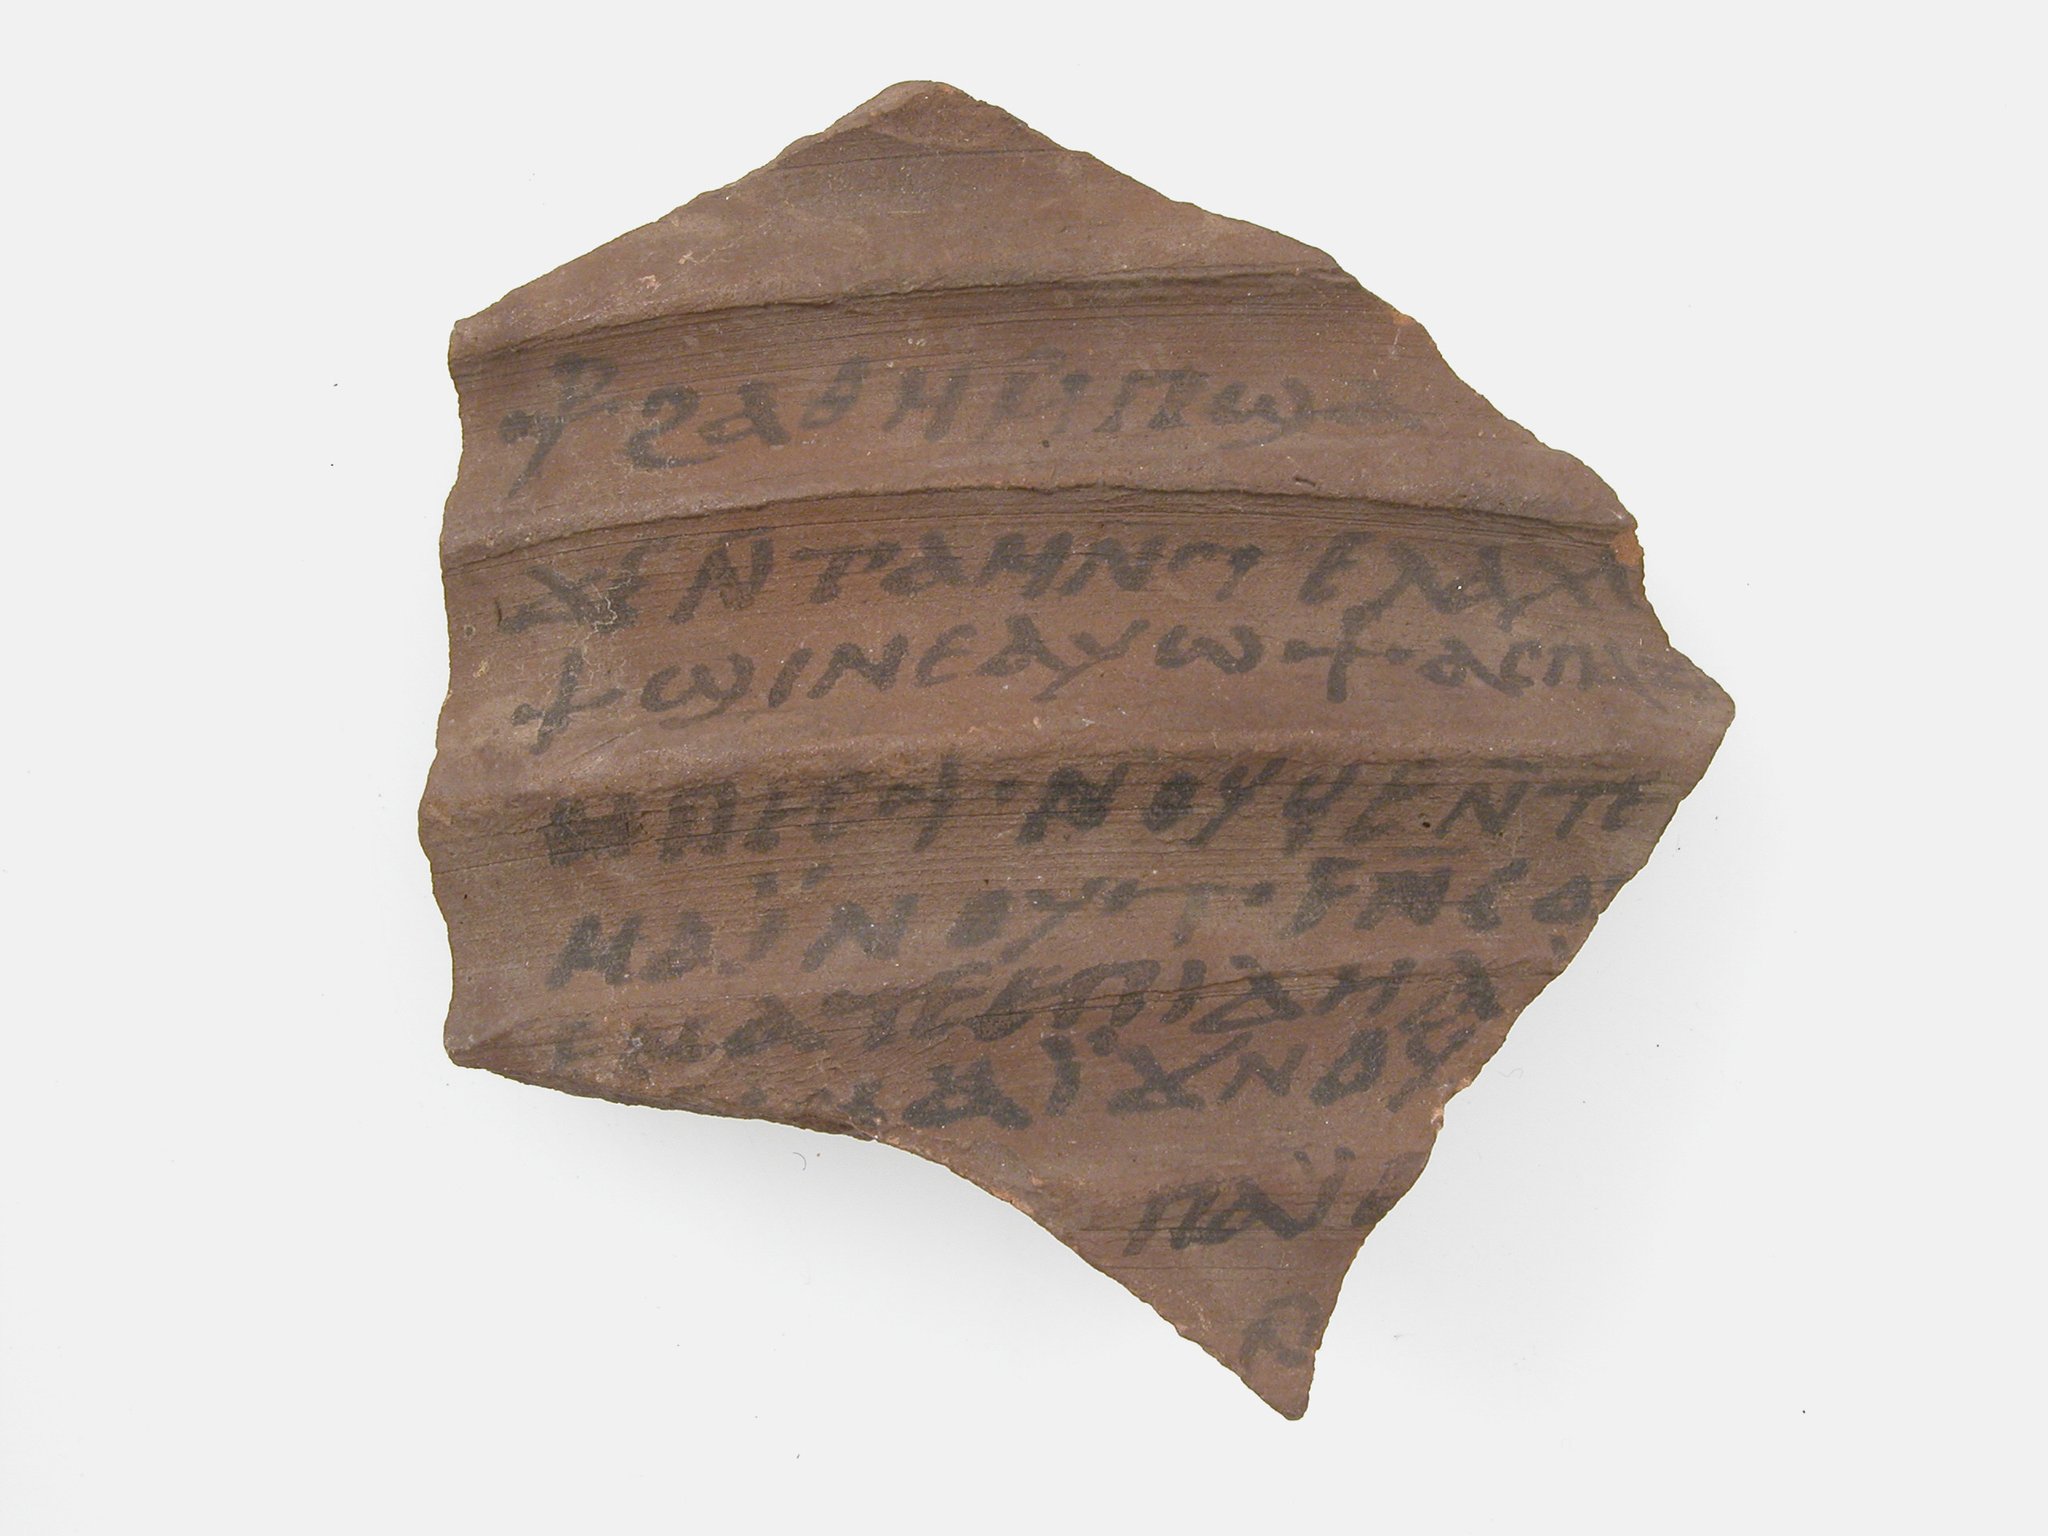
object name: ostrakon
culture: coptic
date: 301-700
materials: ink, pottery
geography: egypt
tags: documents